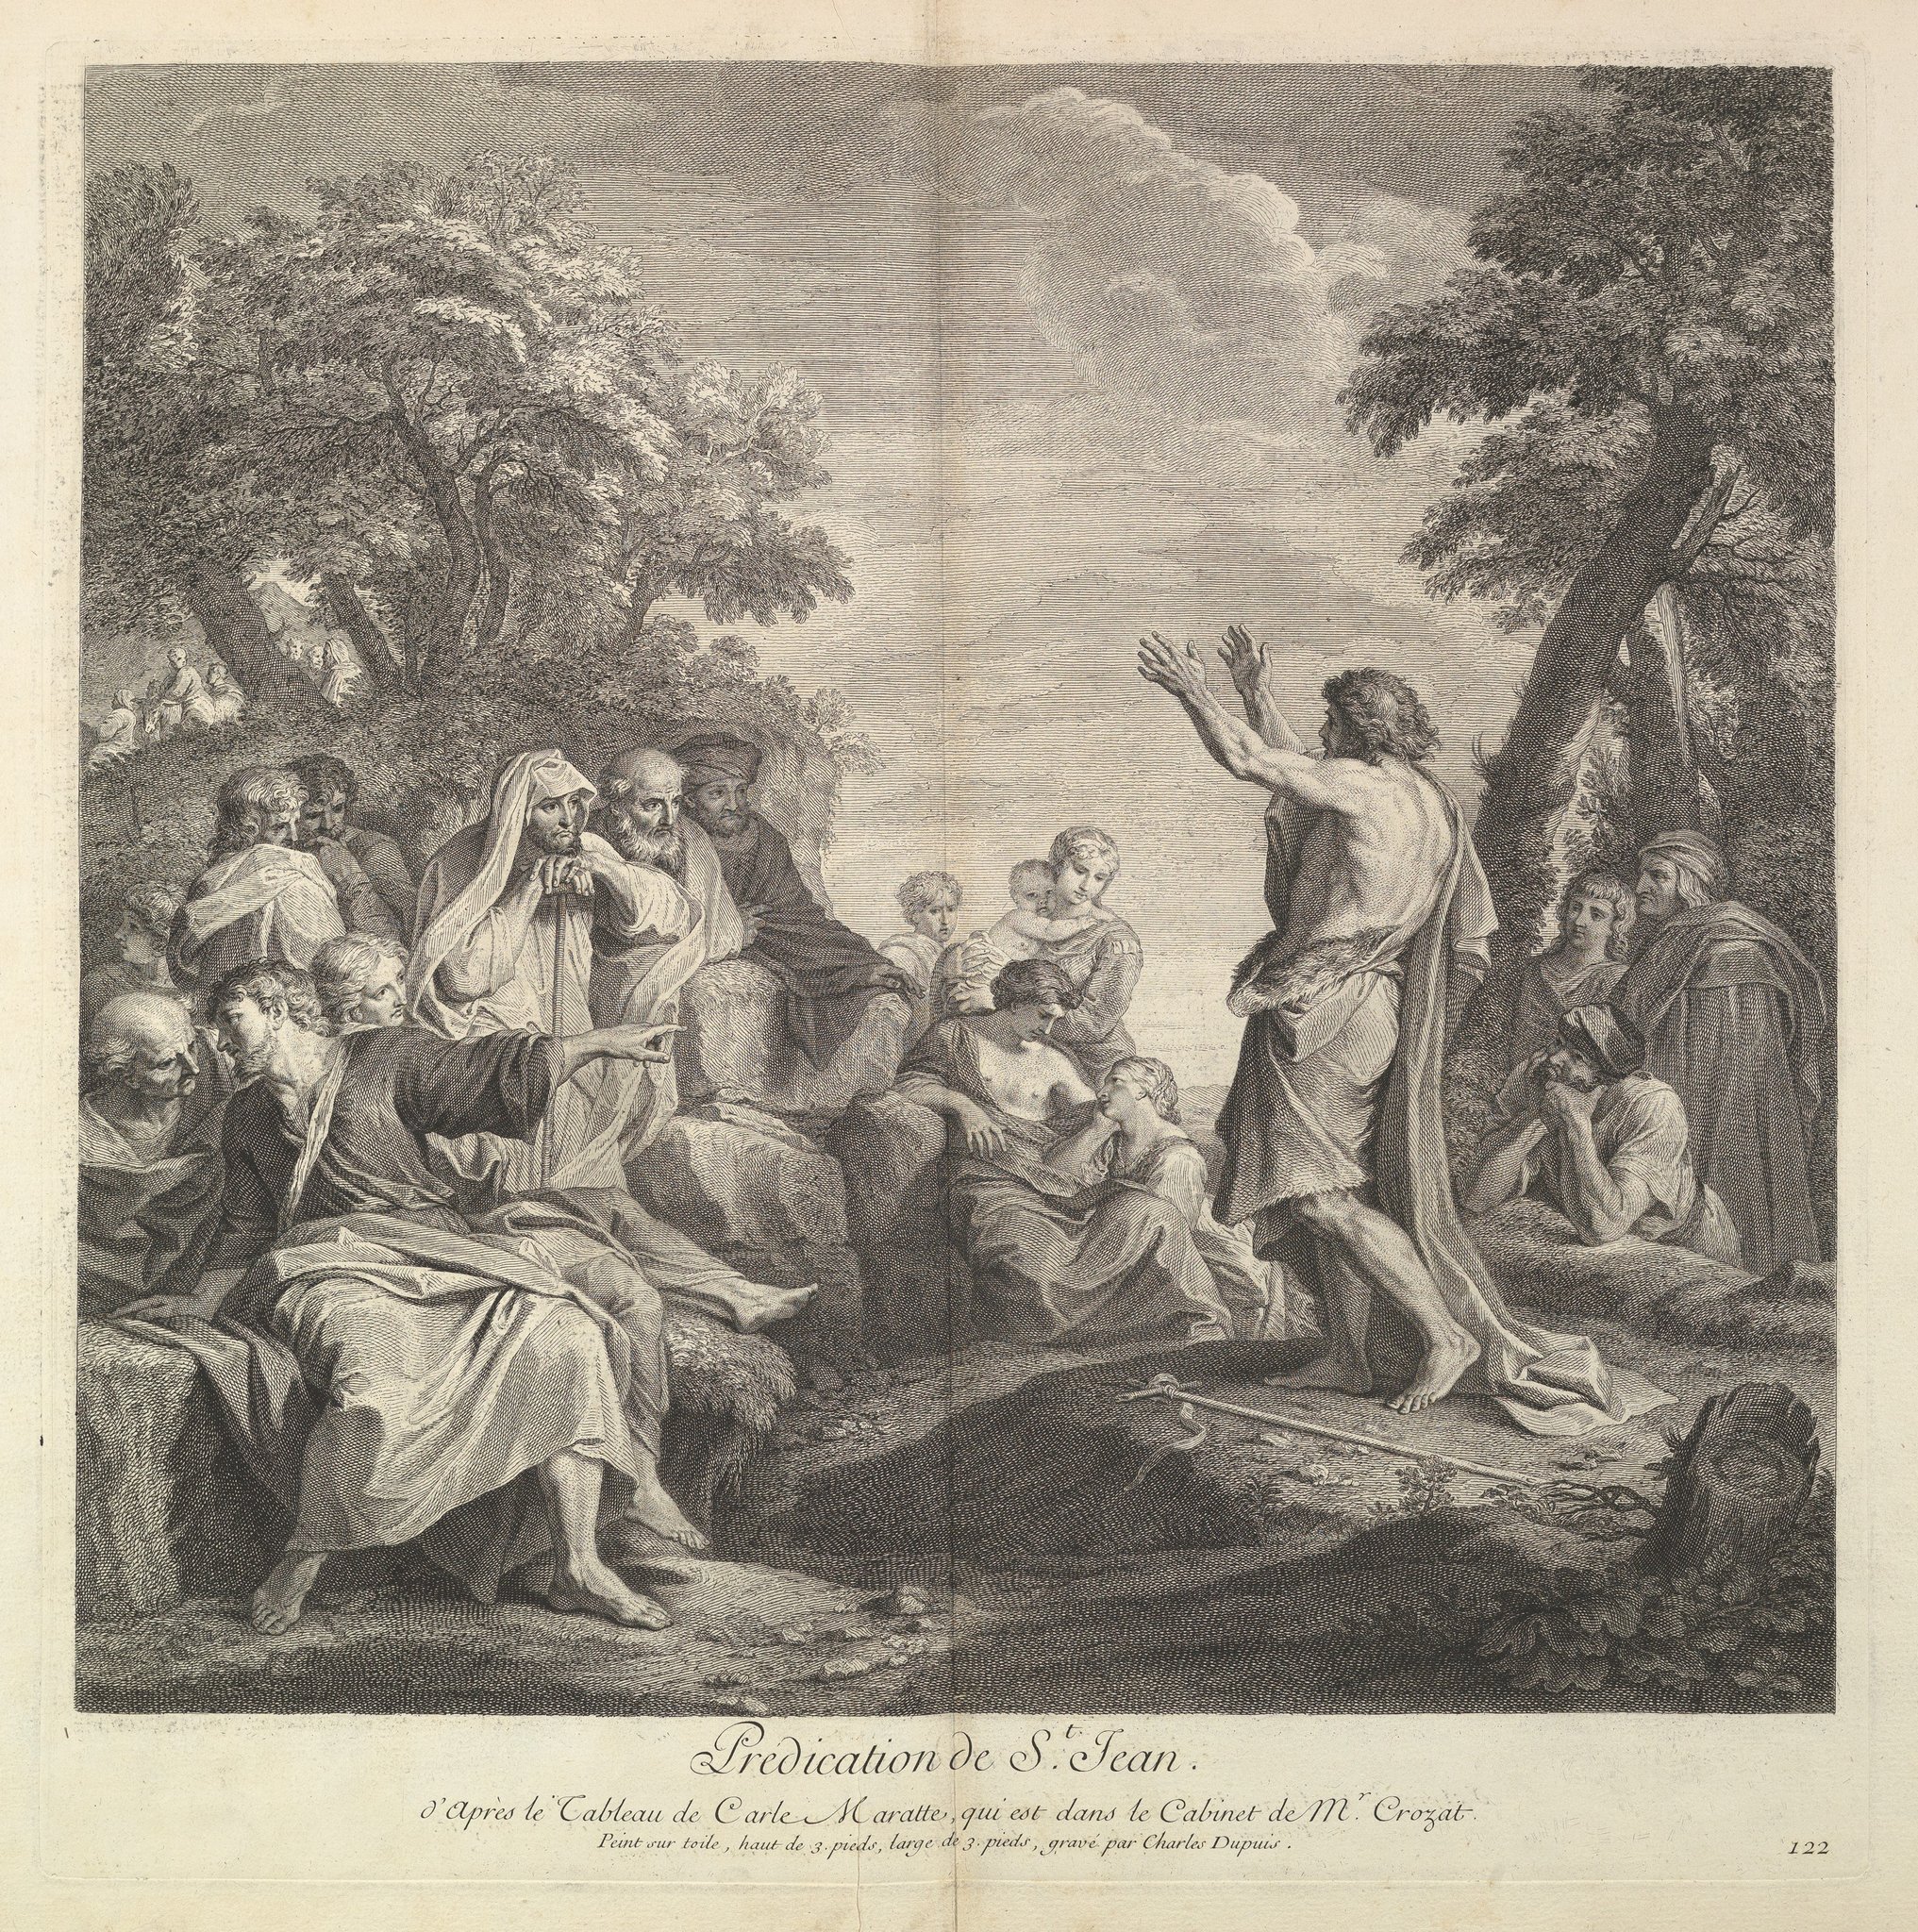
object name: print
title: Predication de St. Jean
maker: charles dupuis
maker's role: artist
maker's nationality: french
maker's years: 1685-1742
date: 1685-1742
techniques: engraving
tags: men,women,saint john the baptist